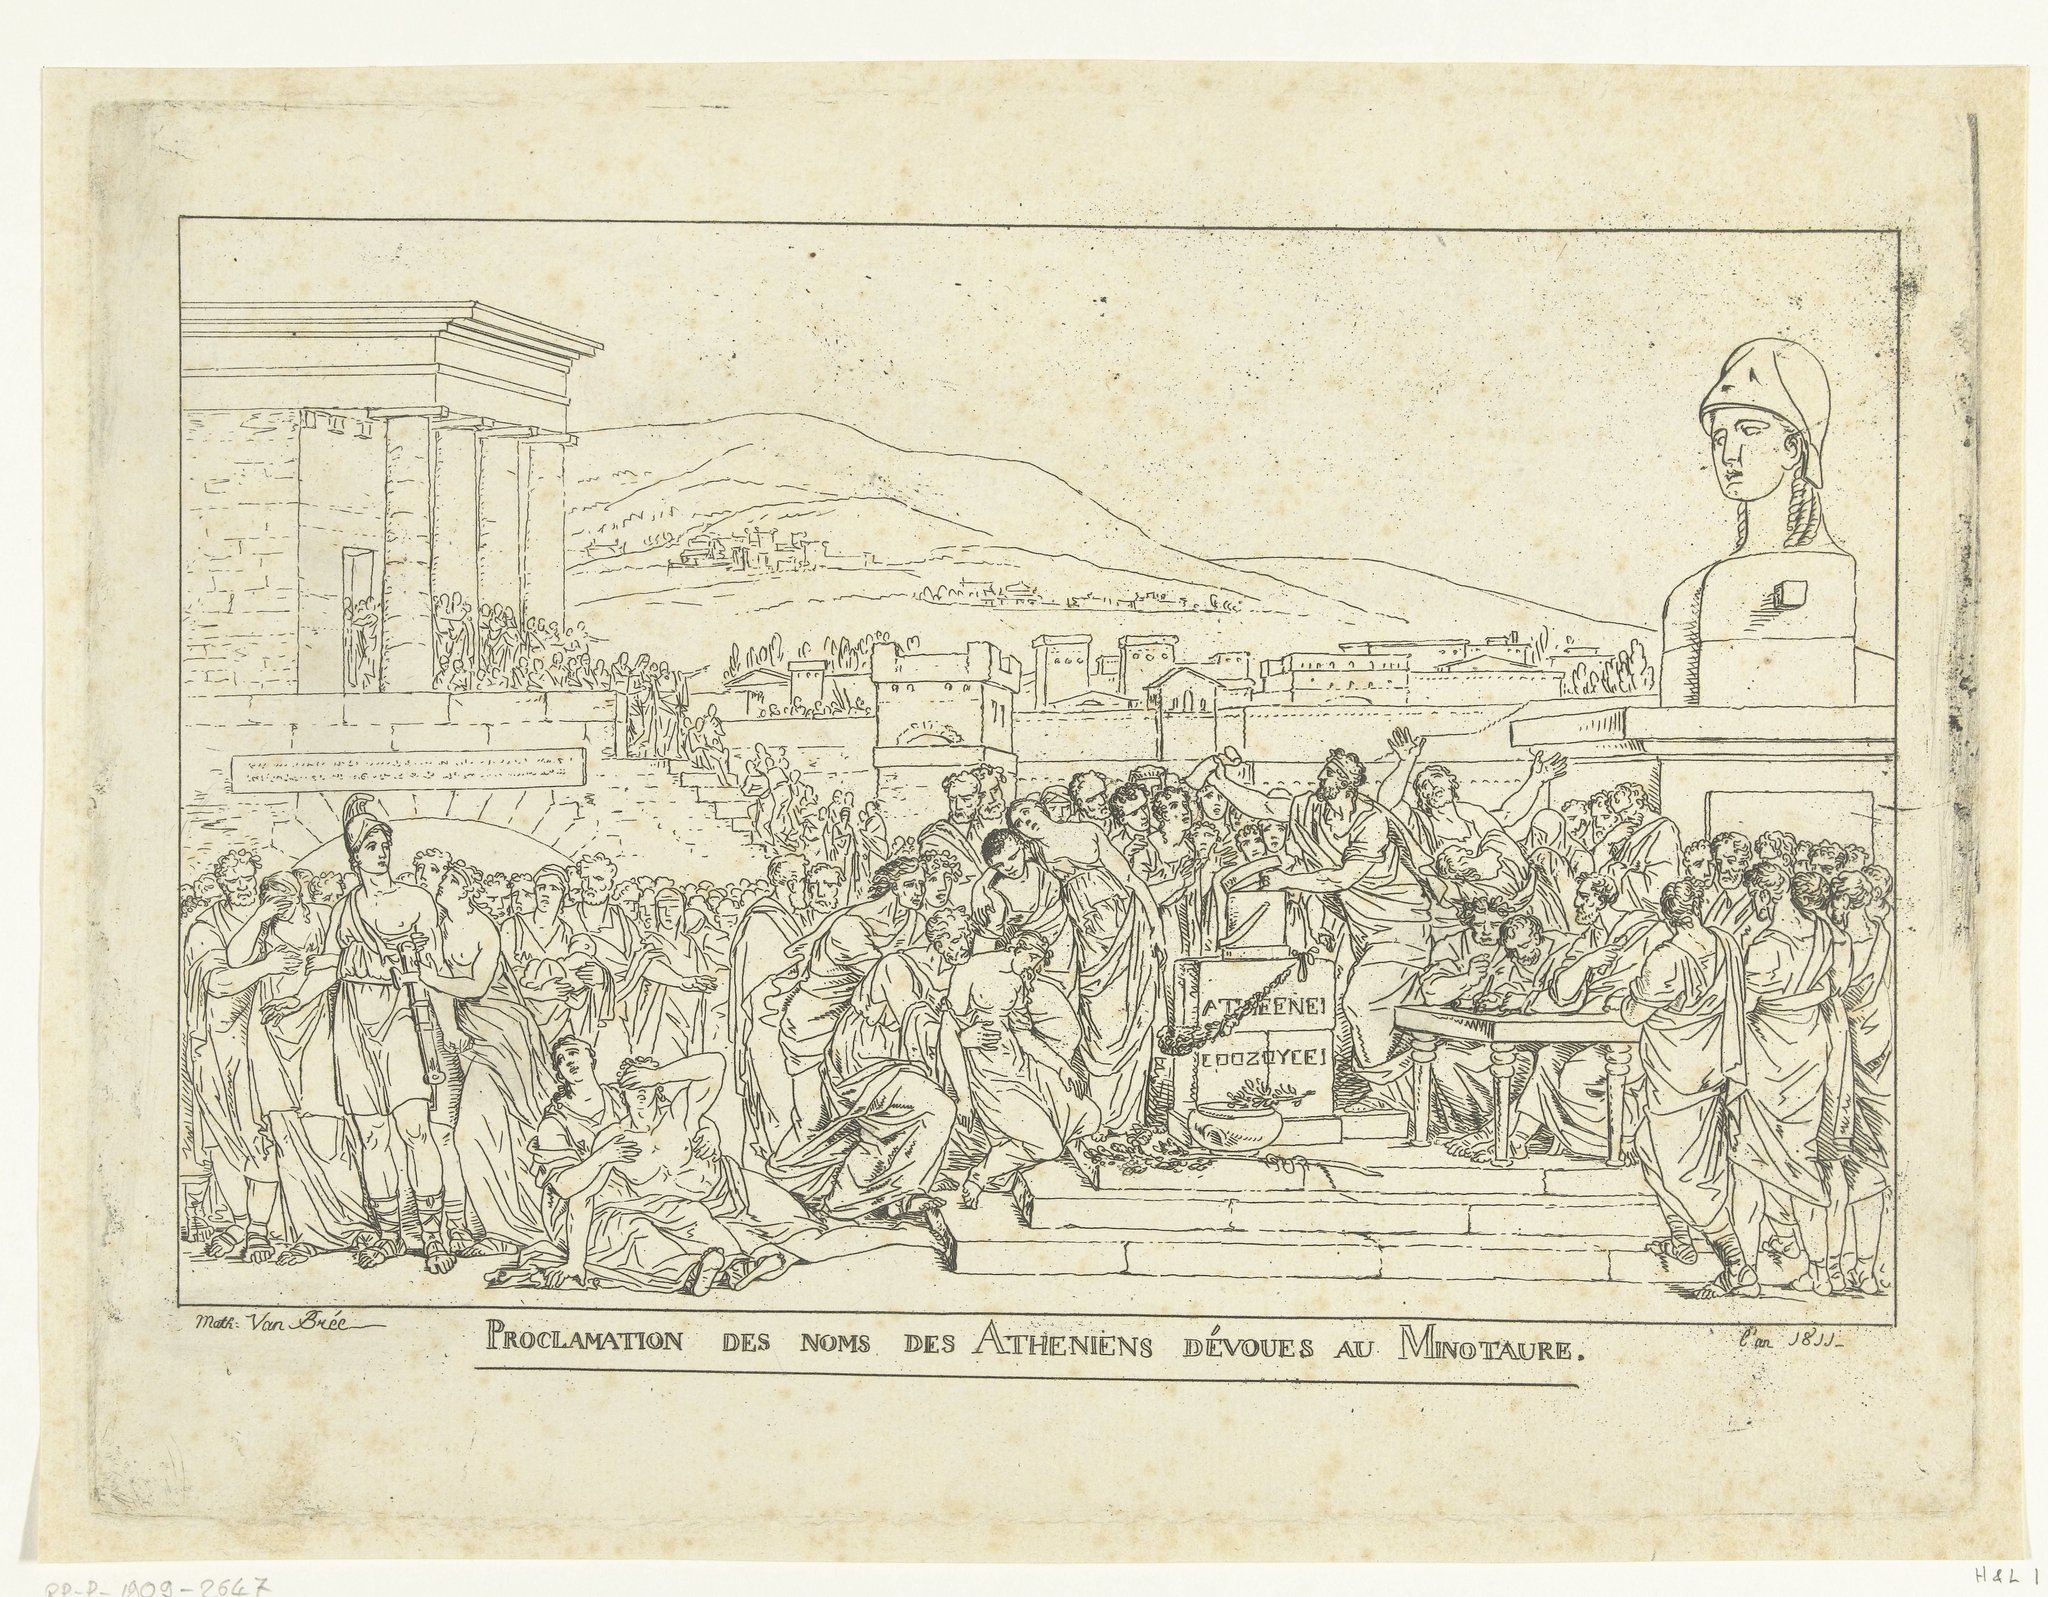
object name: print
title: Het orakel bepaalt de namen van de jongeren die aan Minotaurus geofferd moeten worden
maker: mattheus ignatius van bree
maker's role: draughtsman, print maker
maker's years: 1773-1839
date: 1811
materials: paper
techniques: etching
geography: antwerp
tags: the athenian youths draw lots for the yearly tribute to crete: seven youths and seven maidens to be devoured by the minotaur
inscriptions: collector's mark: Lugt 2228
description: Op een groot plein in Athene is een grote groep mensen bijeen. Op een verhoging staat een urn waaruit het orakel de namen van de Atheense jongeren bepaalt die aan het monster Minotaurus geofferd moeten worden. Links staat de Griekse held Theseus die het monster uiteindelijk zal doden en de Atheners zal verlossen van de last.